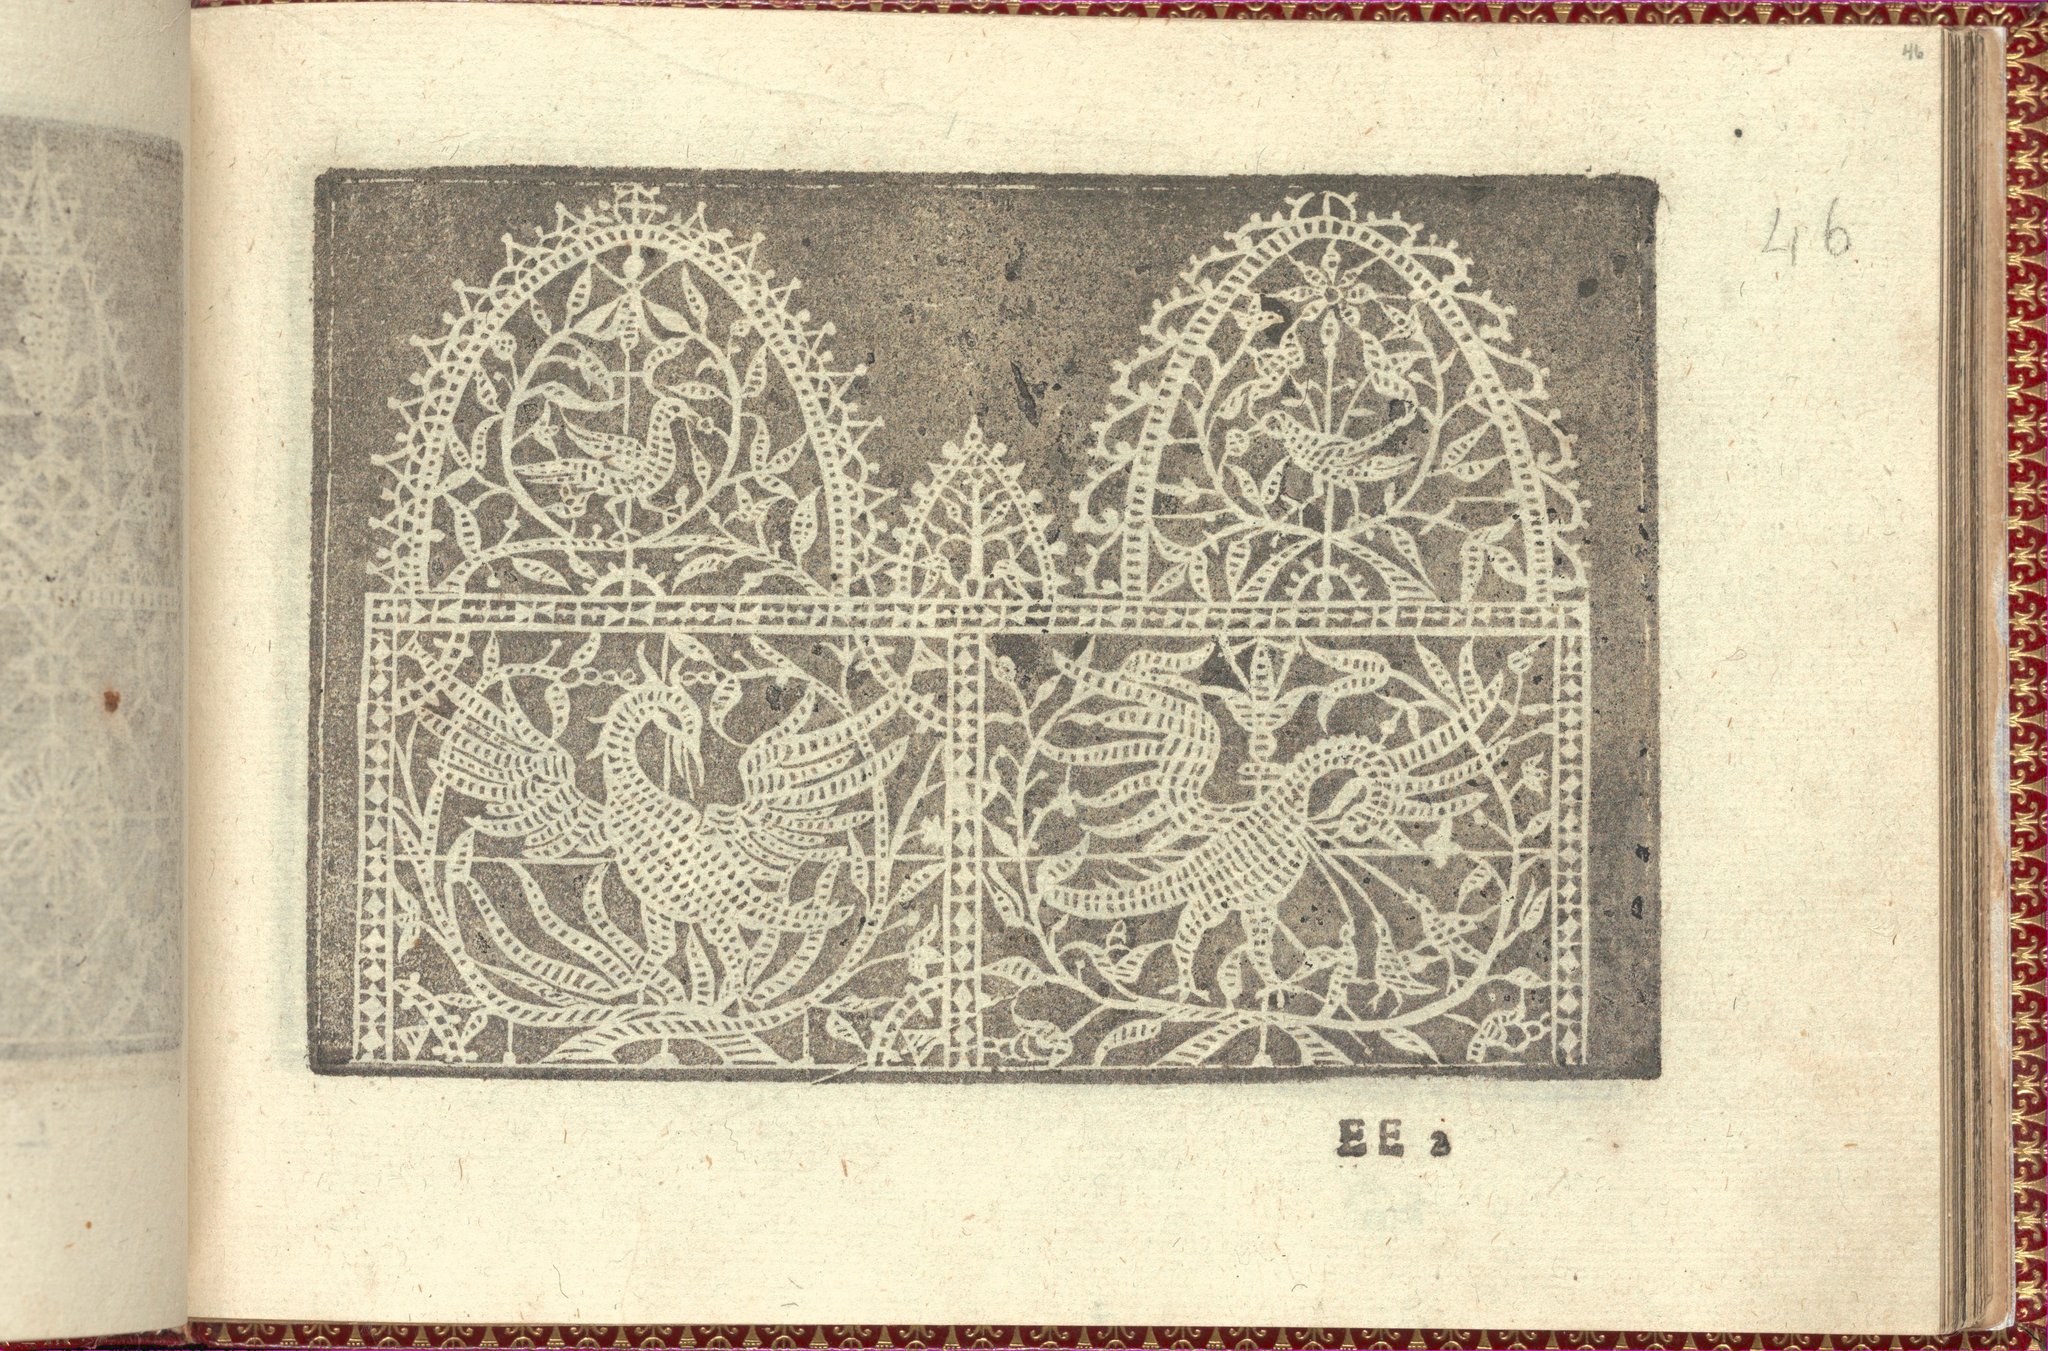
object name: book print ornament architecture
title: Corona delle Nobili et Virtuose Donne: Libro I-IV, page 46 (recto)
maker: cesare vecellio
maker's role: publisher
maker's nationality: italian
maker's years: 1521-1601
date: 1601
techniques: woodcut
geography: italy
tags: birds